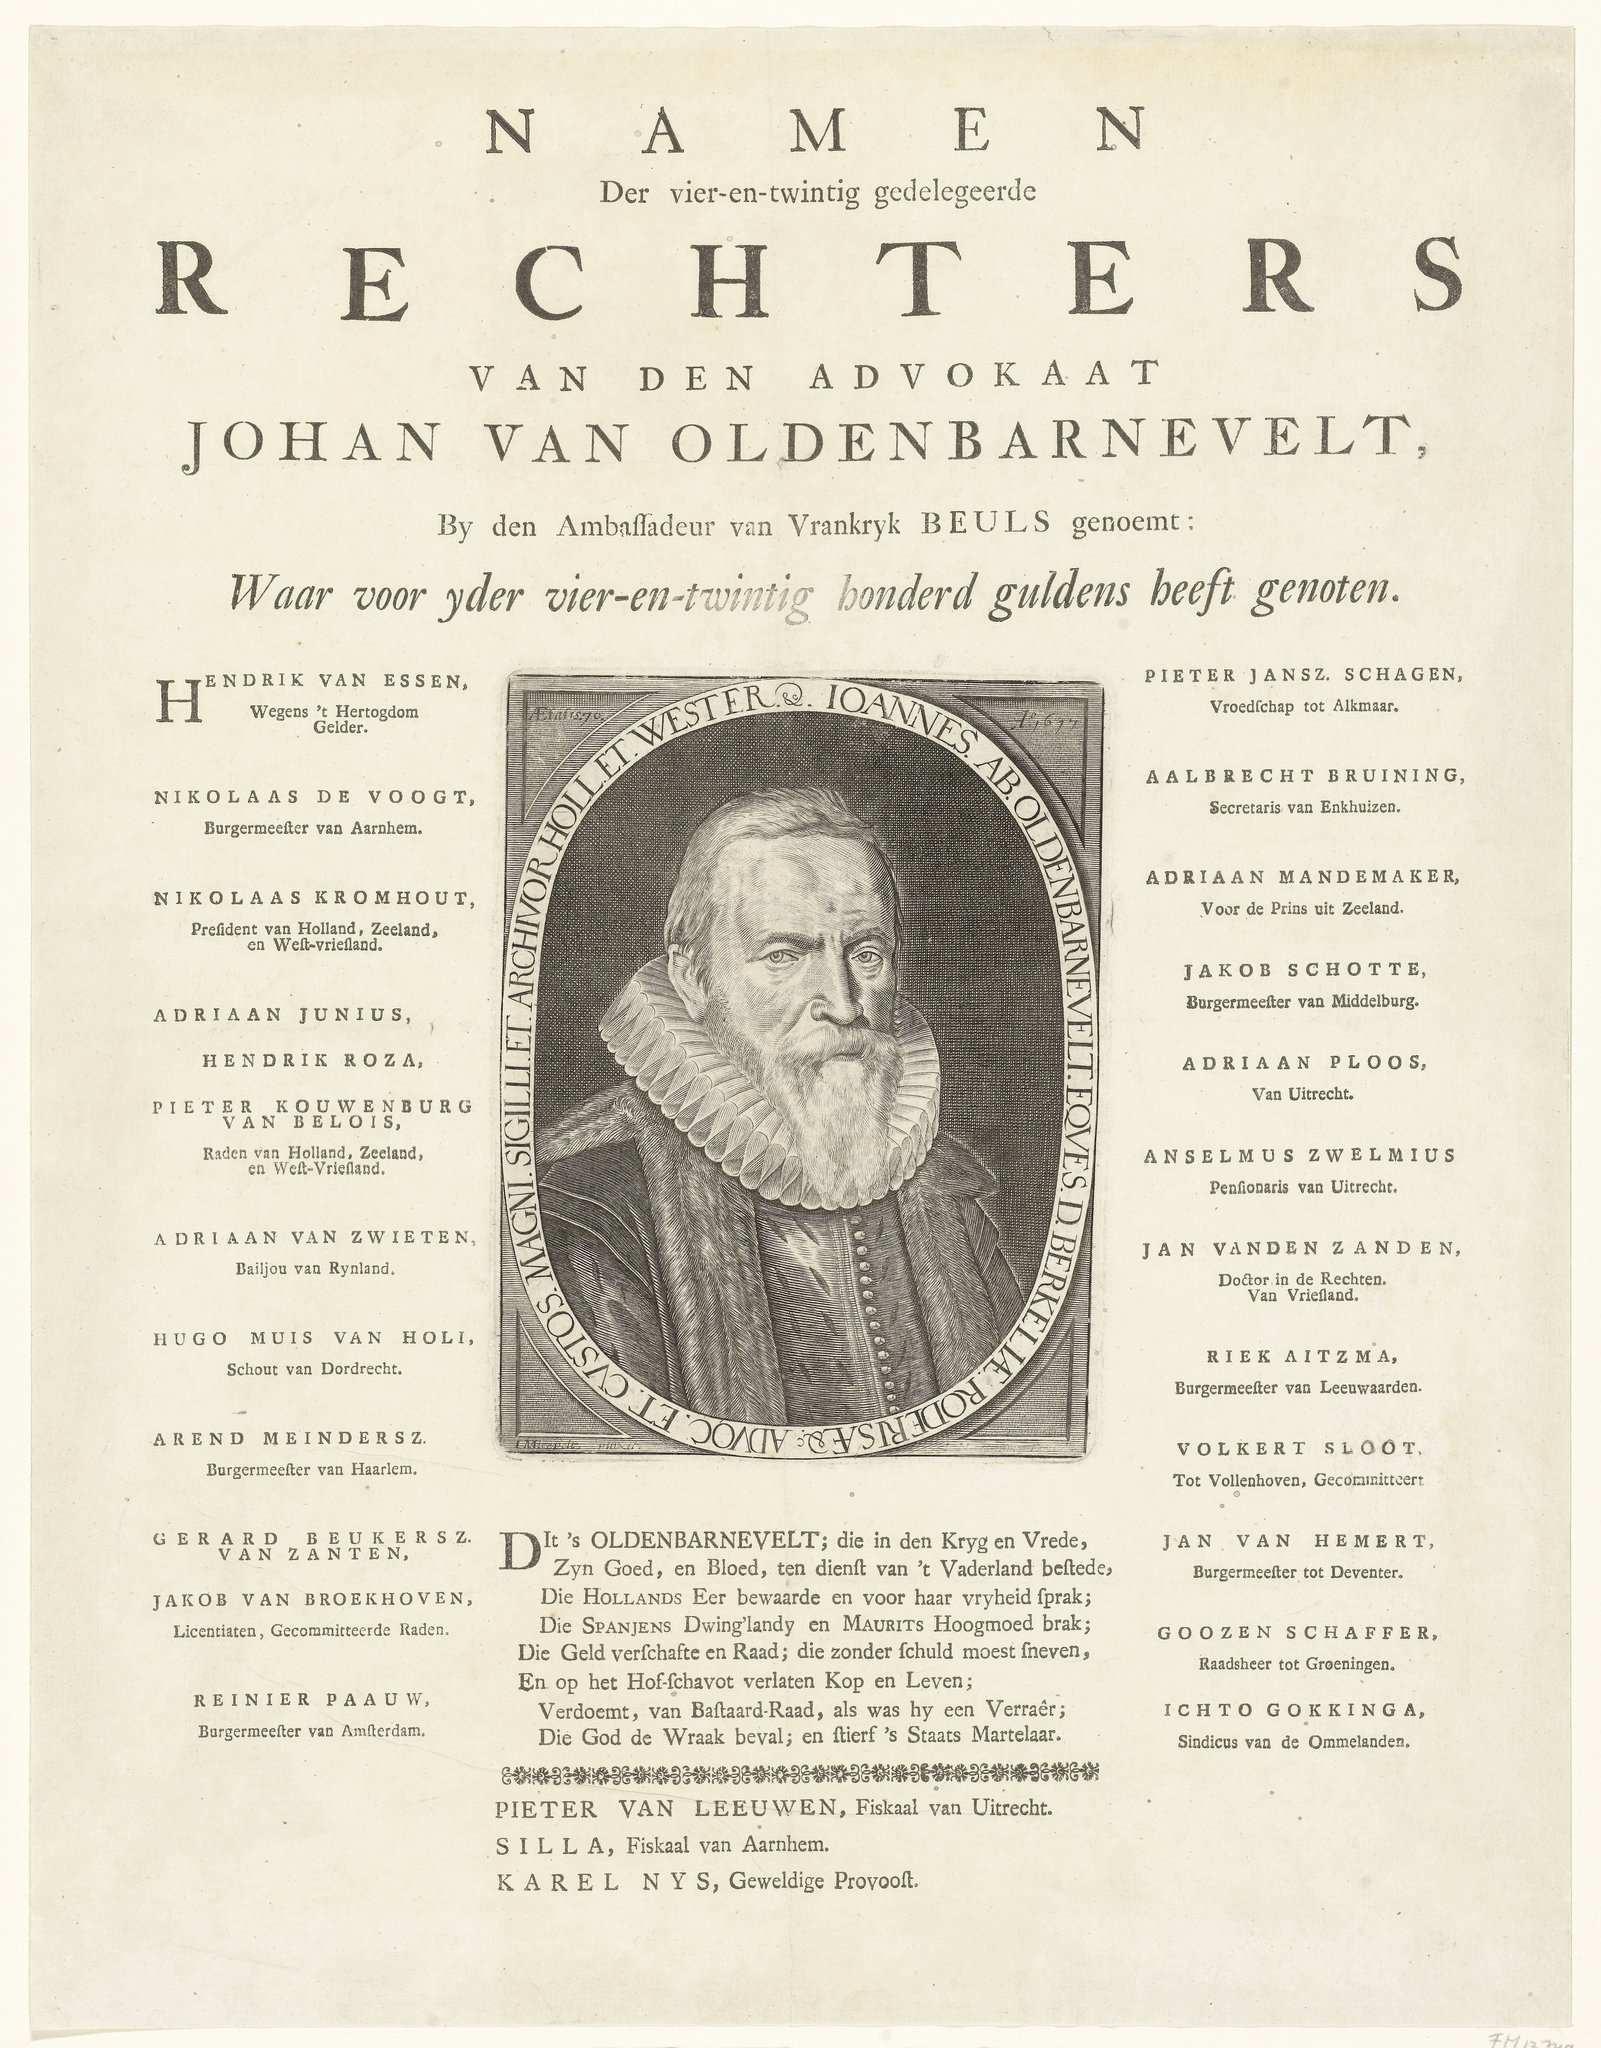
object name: print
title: Namen der vier-en-twintig gedelegeerde Rechters van den advokaat Johan van Oldenbarnevelt, By den Ambassadeur van Vrankryk Beuls genoemt: Waar voor yder vier-en-twintig honderd guldens heeft genoten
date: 1619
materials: paper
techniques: engraving, letterpress printing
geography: northern netherlands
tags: the hague, johan van oldenbarnevelt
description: Blad met een portret van Johan van Oldenbarnevelt, omringd door de namen van de vierentwintig rechters die hem ter dood hebben veroordeeld, februari 1619. Onder het portret staat een vers waarin de eer en onschuld van de landsadvocaat worden geroemd.